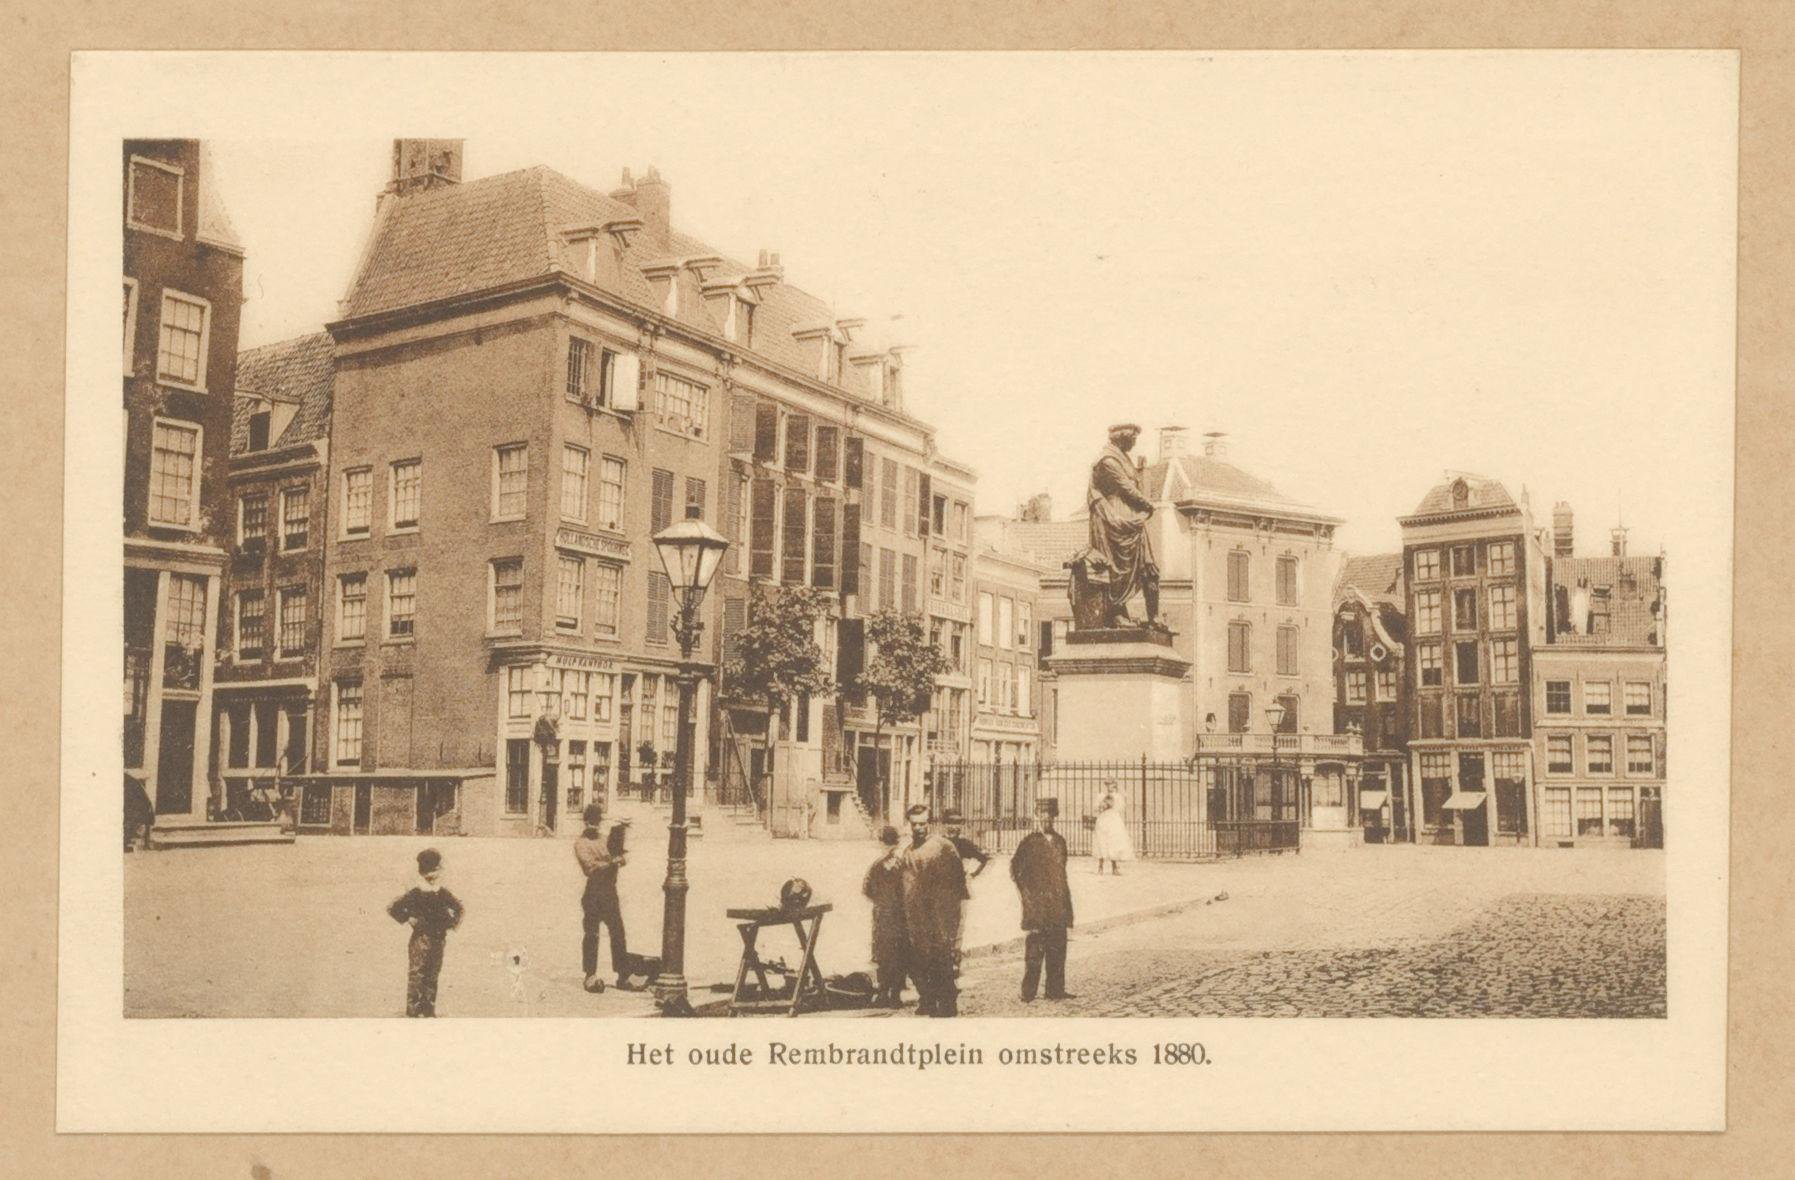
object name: ansichtkaart, prentbriefkaart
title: Gezicht op het Rembrandtplein met het Rembrandtmonument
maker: Anonymous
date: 1905-1930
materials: cardboard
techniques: photograph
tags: square, place, circus, etc., city-view in general; 'veduta', monument, statue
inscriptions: collector's mark: ‘12-’ Lugt 1641b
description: Onderwerpsrubriek binnen de Atlas Amsterdam: Rembrandtplein (Botermarkt), Roeterseiland.